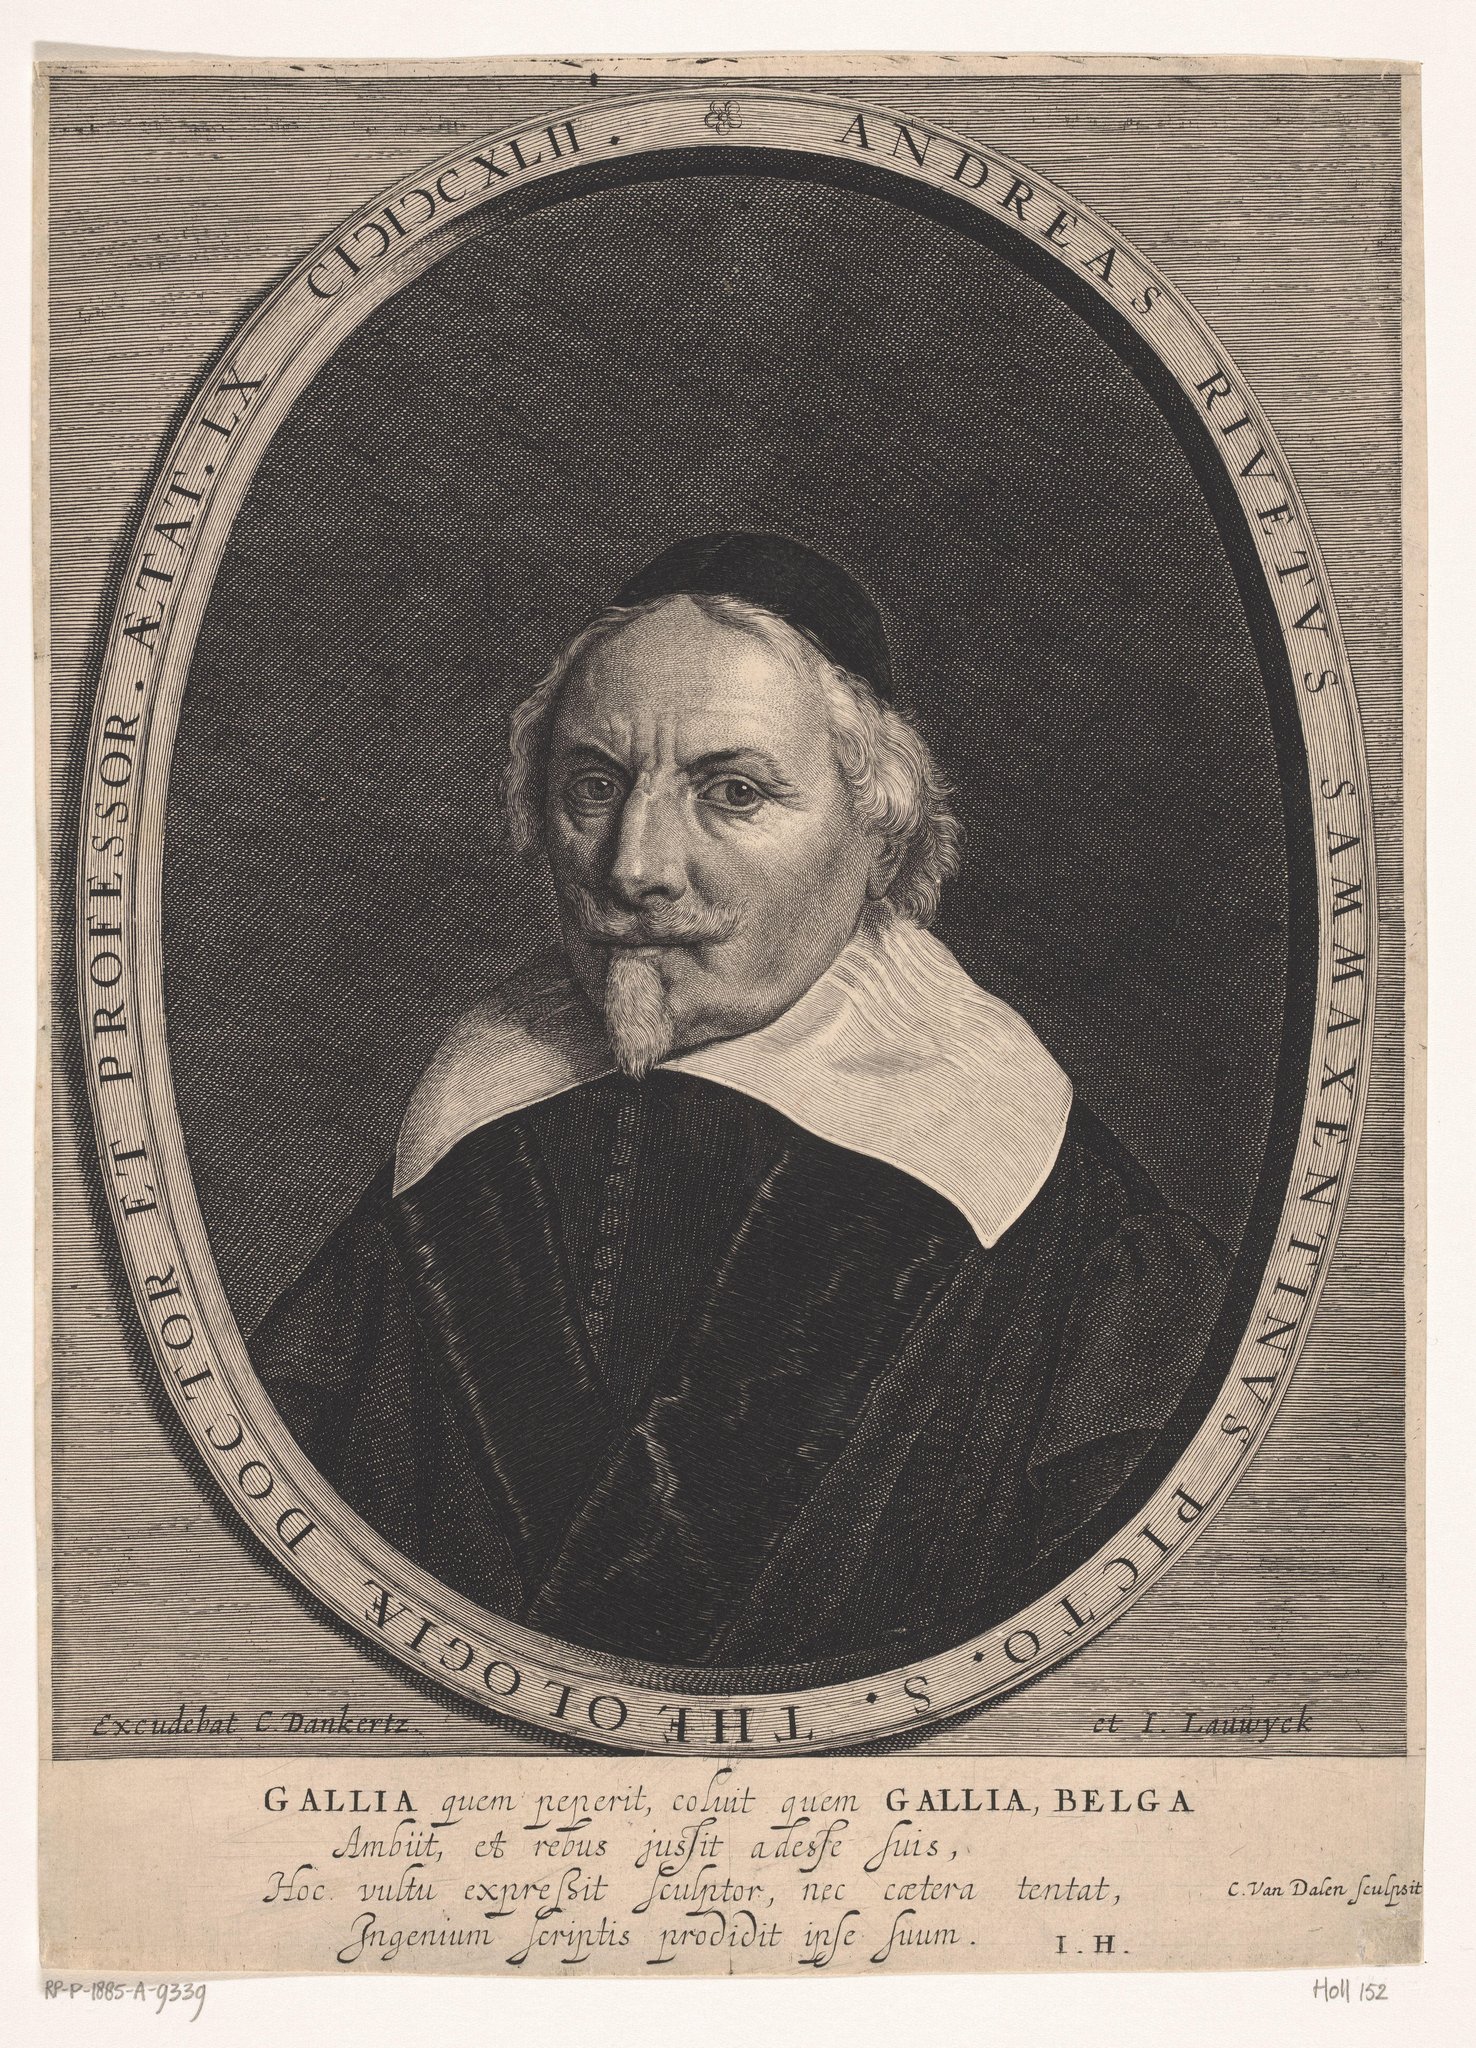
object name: print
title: Portret van André Rivet op 60-jarige leeftijd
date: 1632-1665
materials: paper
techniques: engraving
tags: andré rivet, professor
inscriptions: collector's mark: Lugt 2228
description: Portret van André Rivet op 60-jarige leeftijd. Borststuk van de theoloog gekleed in toga in ronde omlijsting. In de marge onder een Latijns vers.